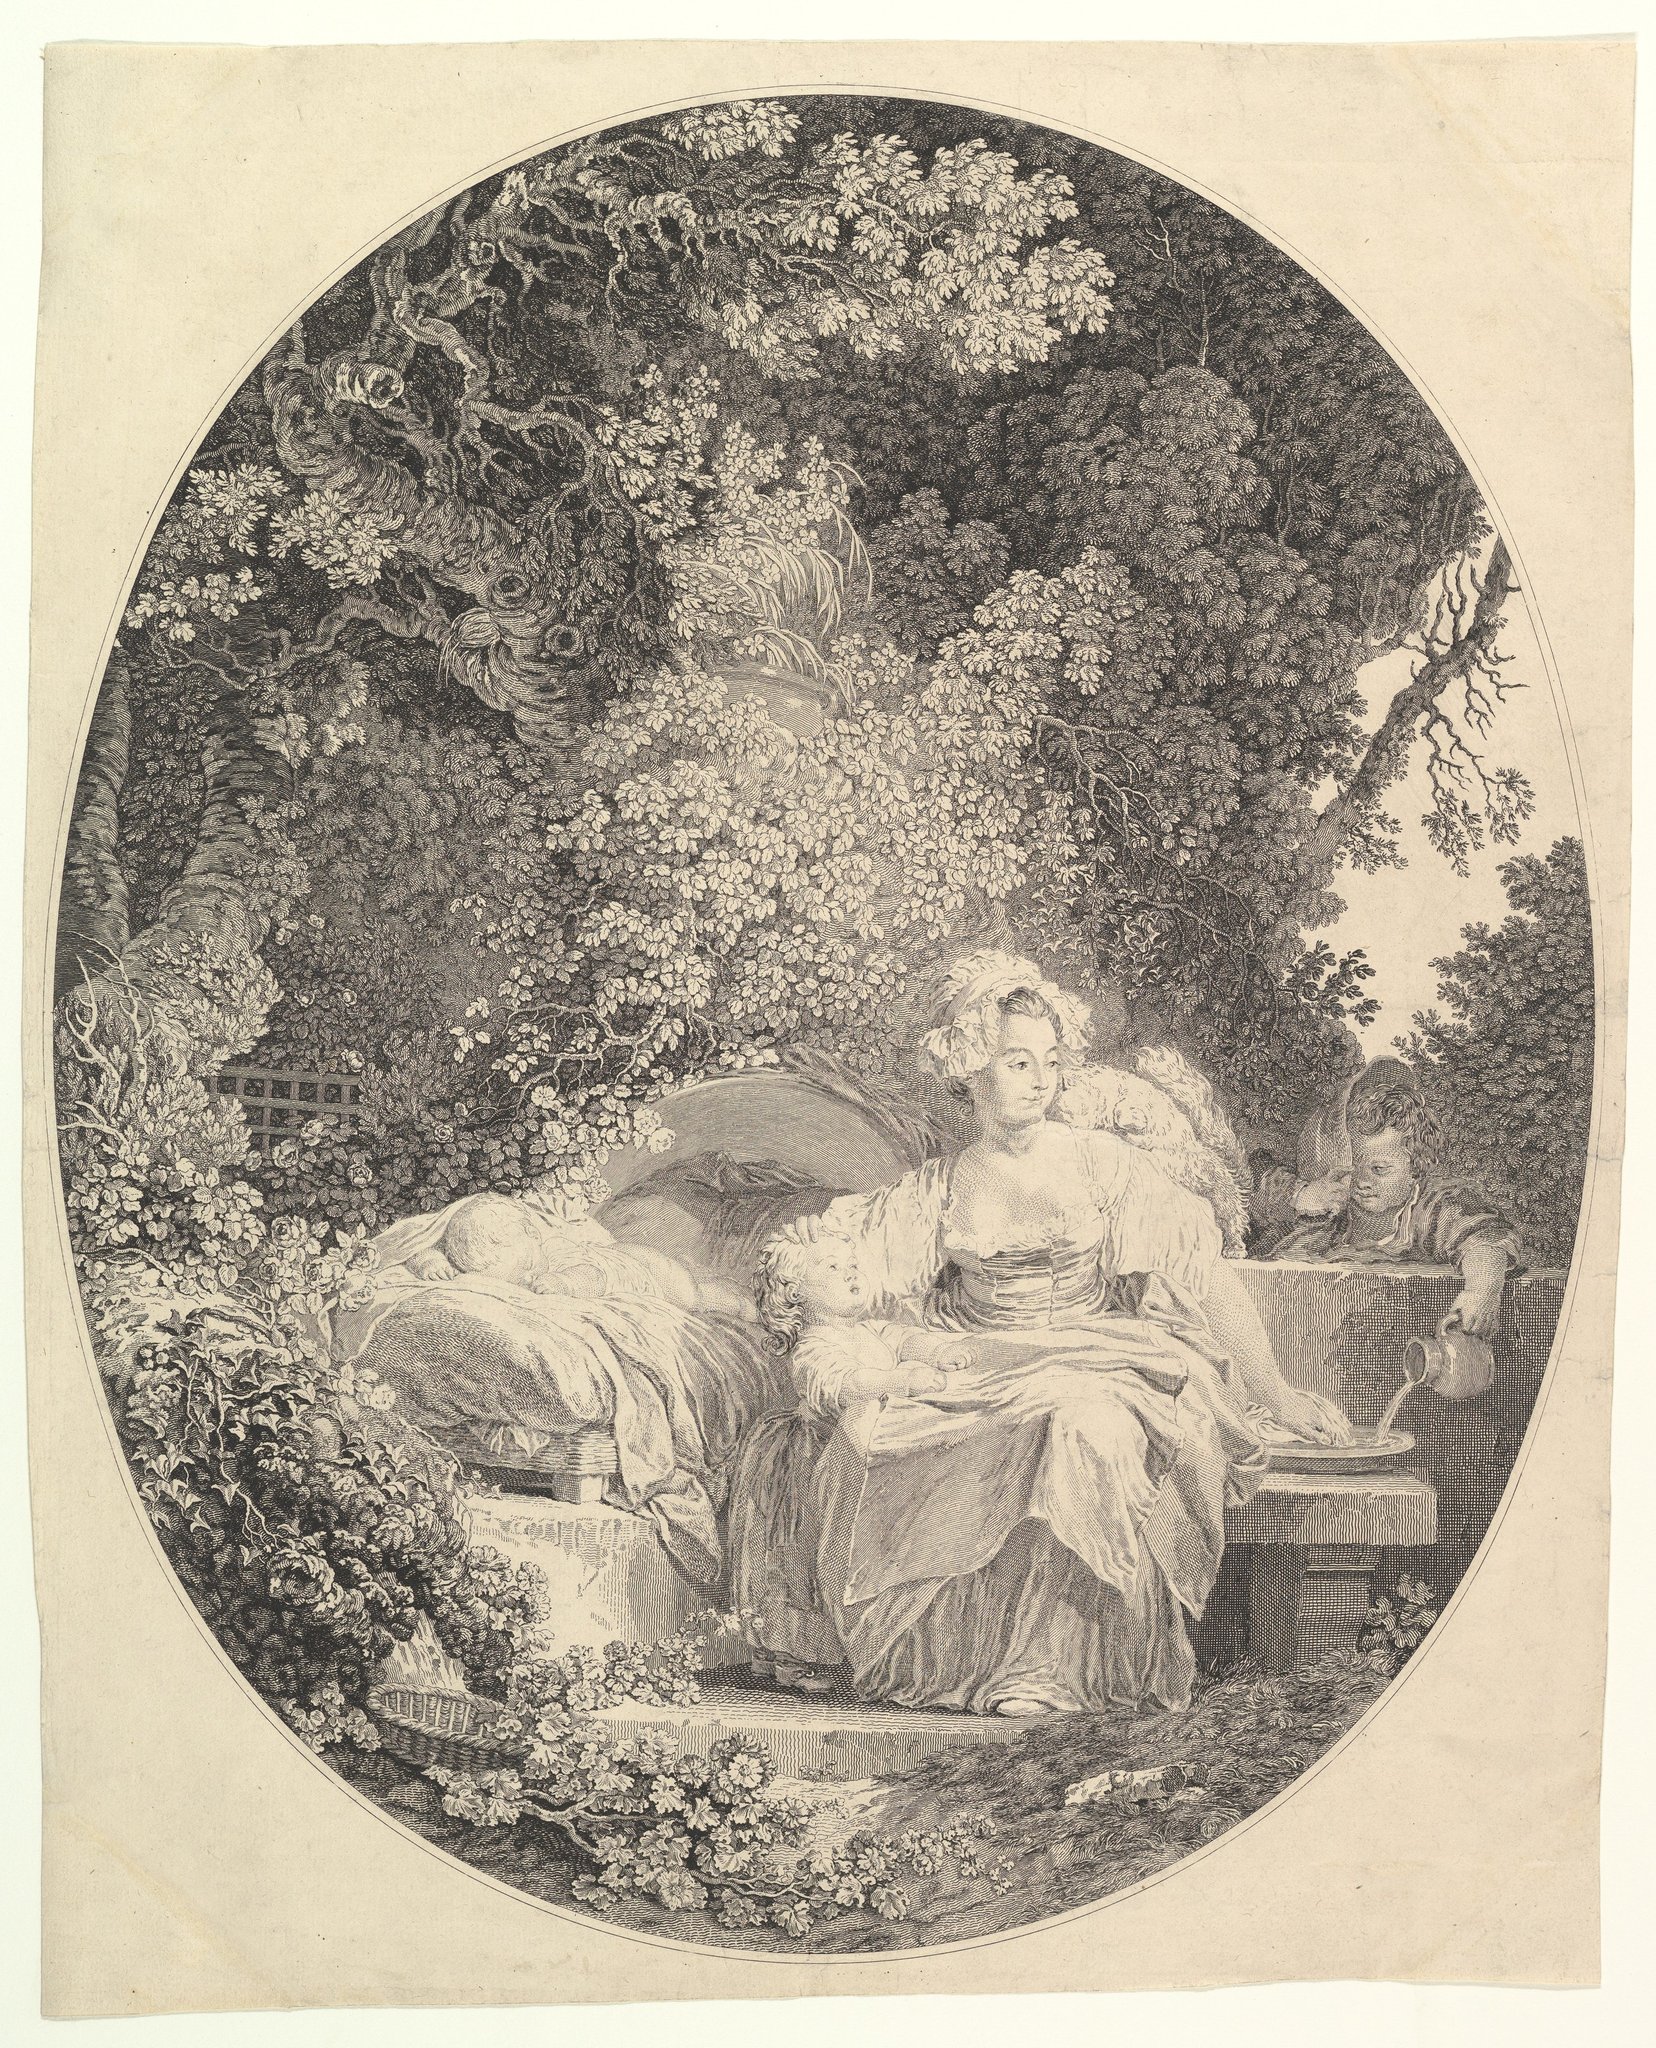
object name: print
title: La Bonne Mere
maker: jean honoré fragonard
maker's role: artist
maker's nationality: french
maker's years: 1732-1806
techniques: etching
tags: children,infants,mothers